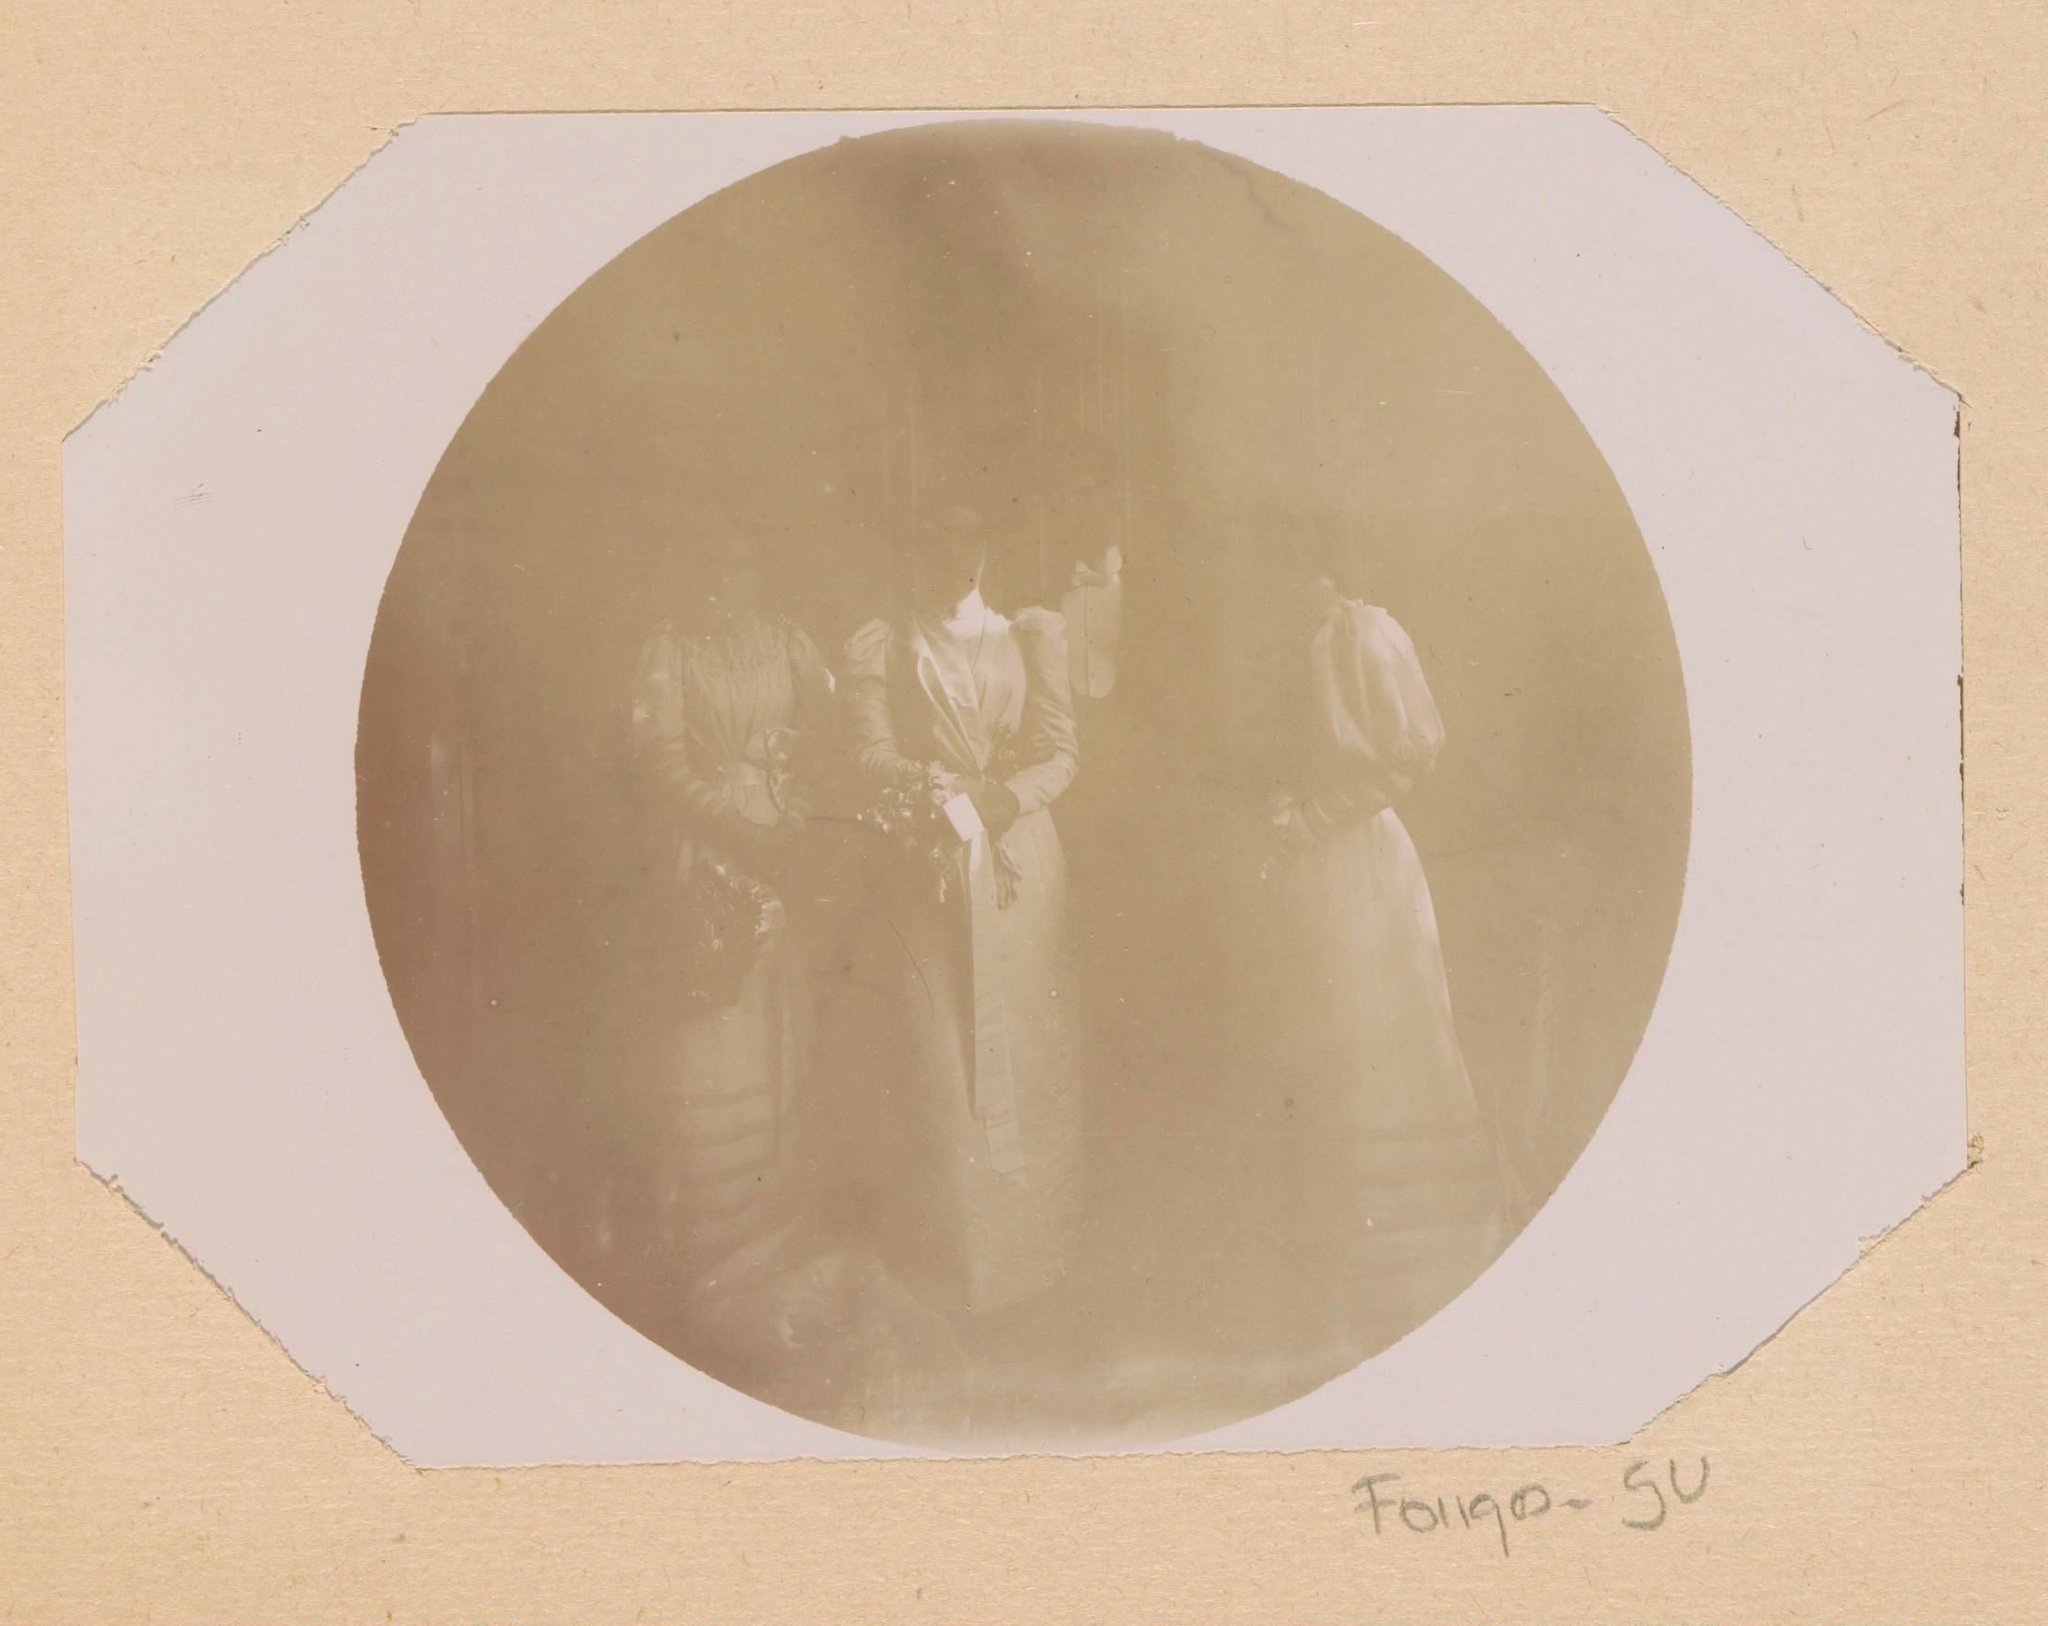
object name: photograph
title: Cato Piek-Asser en Hendrik Lodewijk Asser tussen twee bruidsmeisjes tijdens hun bruiloft, links staat Gesiena Piek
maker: johanna margaretha piek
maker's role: fotograaf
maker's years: 1870-1947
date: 1893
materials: paper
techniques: gelatin silver print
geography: amsterdam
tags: amsterdam, bridesmaid, bride and groom in wedding-dress